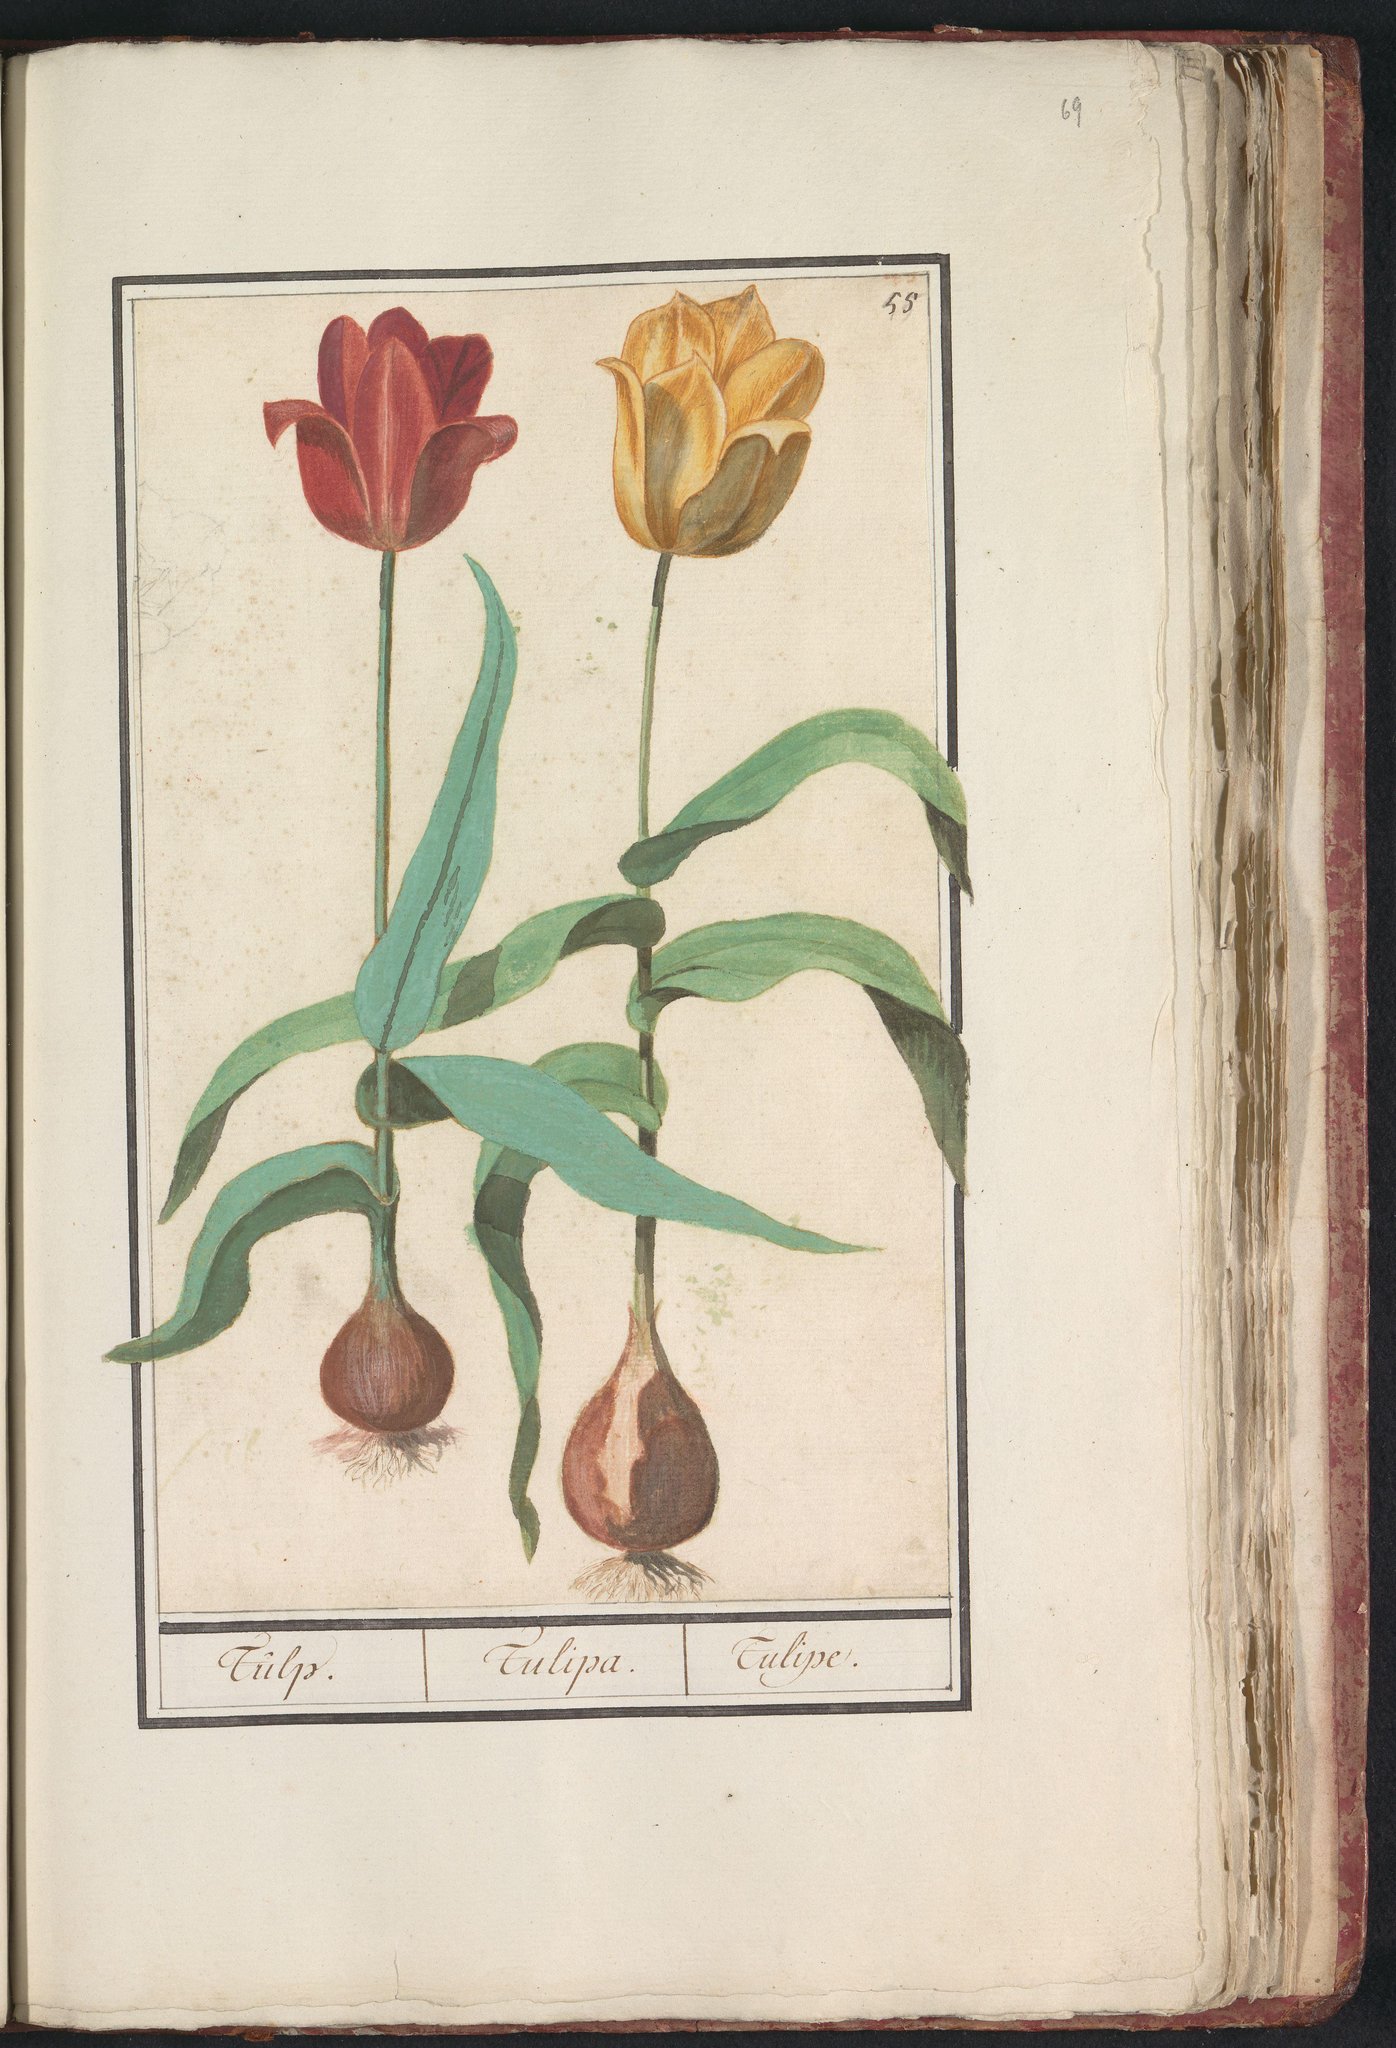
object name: drawing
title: Tulp (Tulipa)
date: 1596-1610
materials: chalk, paint, paper, watercolor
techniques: brush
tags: flowers: tulip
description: Rode en gele tulp met bol. Genummerd rechtsboven: 55. Onderdeel van het eerste album met tekeningen van bloemen en planten. Achtste van twaalf albums met tekeningen van dieren, vogels en planten bekend rond 1600, gemaakt in opdracht van keizer Rudolf II. Met toelichting in Nederlands, Latijn en Frans.